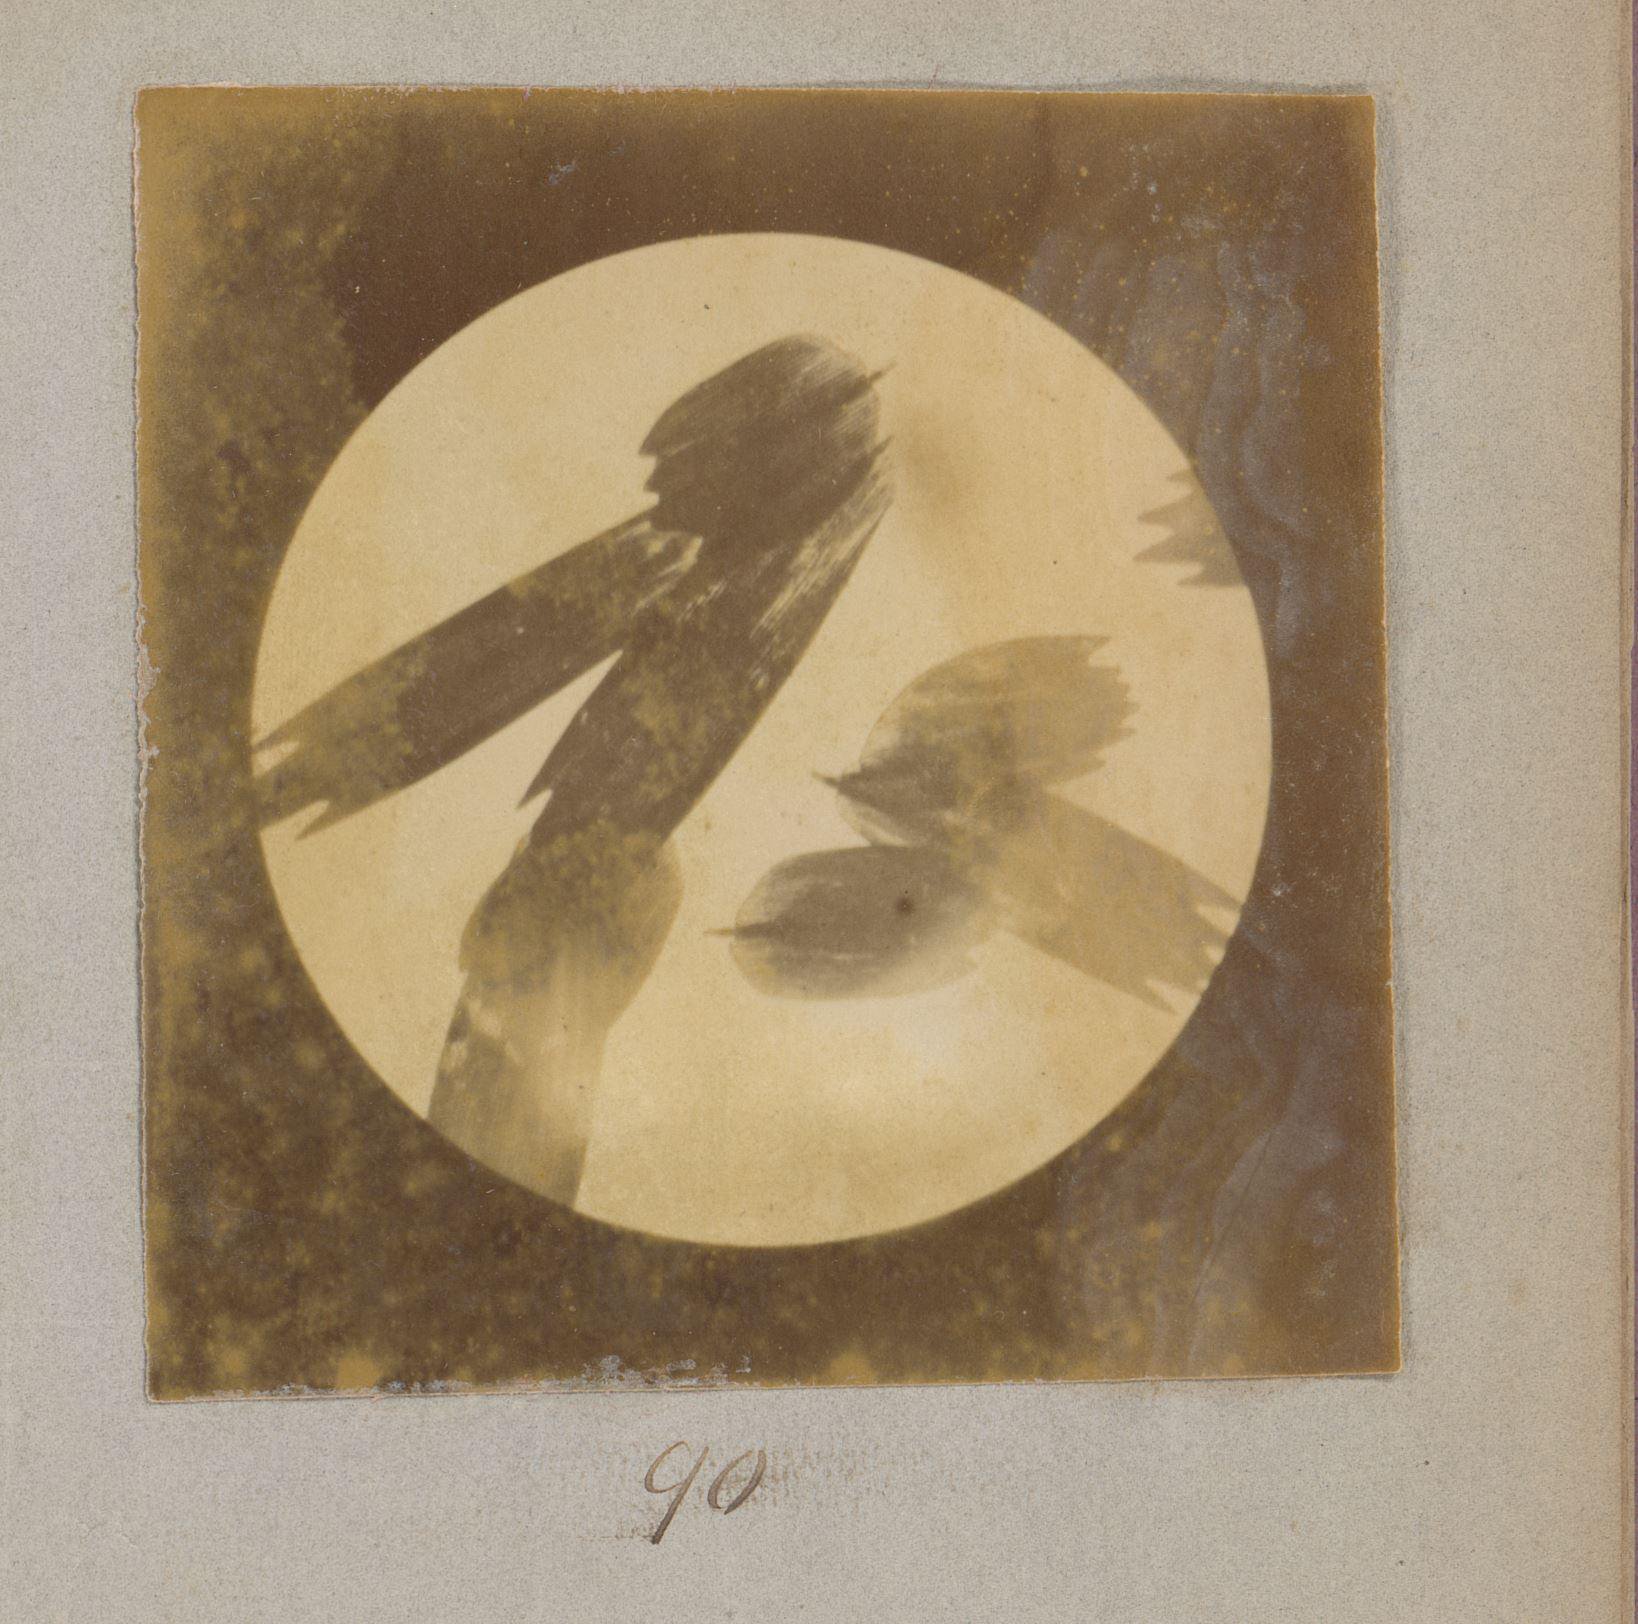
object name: album leaf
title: Microscopische opname van een vlindervleugel, tachtig keer vergroot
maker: marinus pieter filbri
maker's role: instrument maker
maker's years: 1852-1917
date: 1887-1888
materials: paper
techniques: albumen print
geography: netherlands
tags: insects: butterfly, netherlands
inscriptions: inscription: ‘No. 90. Benaming Stofjes van de vleugel eener Kapel, vergroot 80 x, pose 5 min., bemerking Lomberg’, number: ‘90’